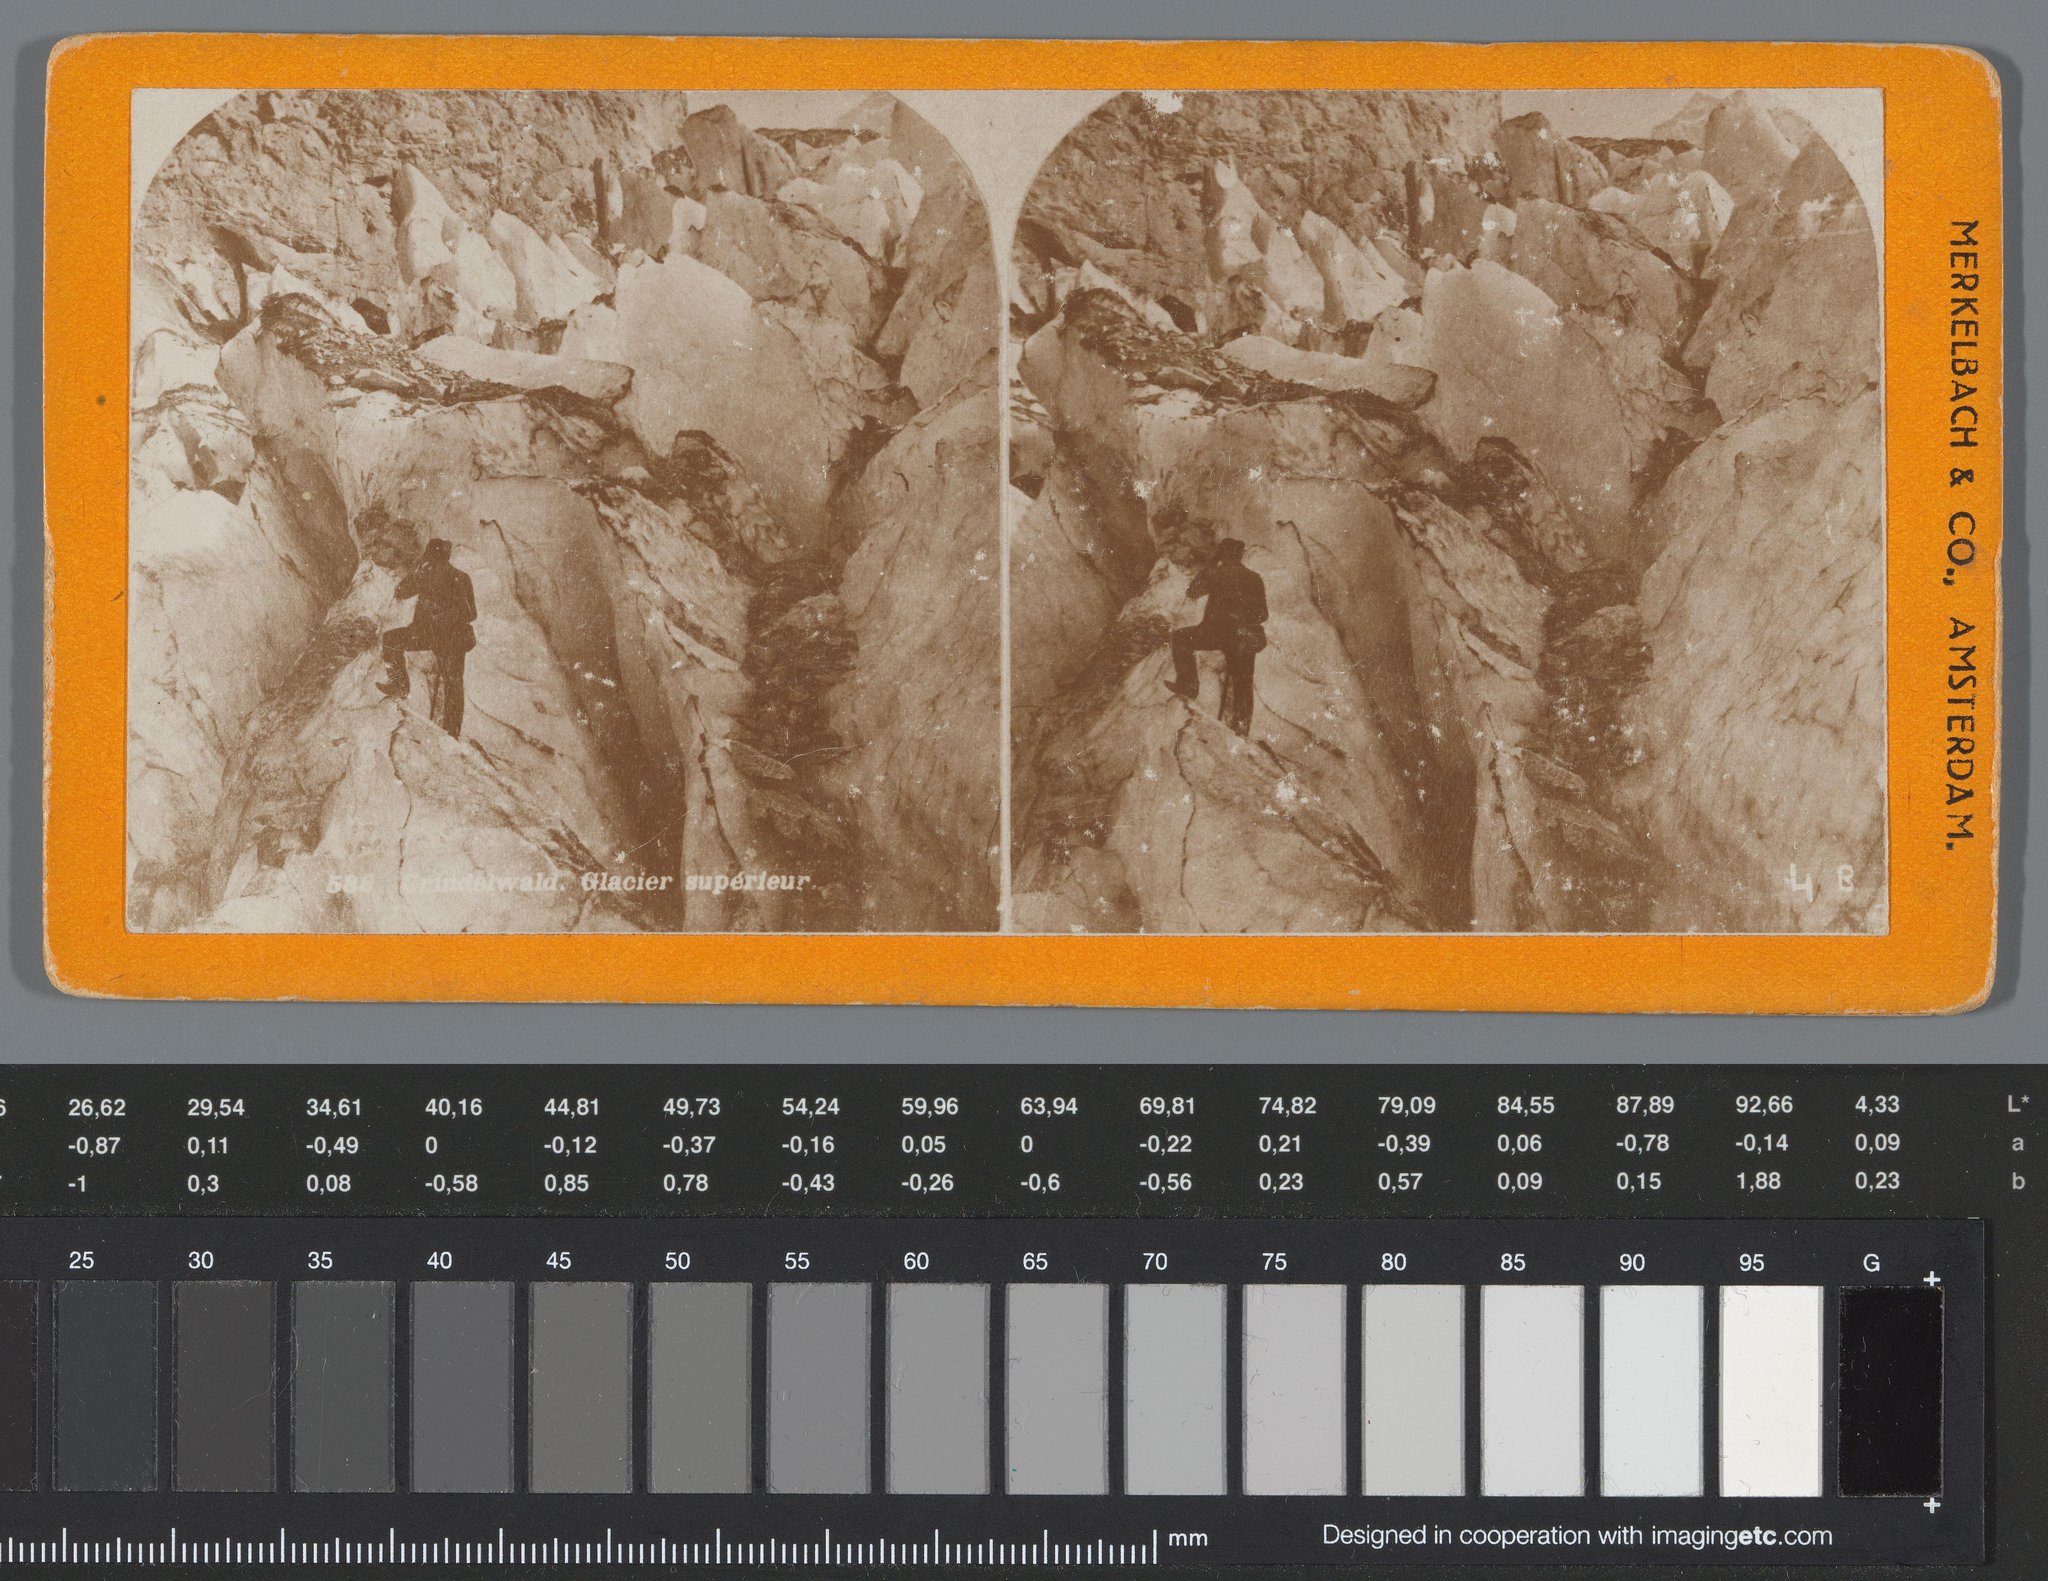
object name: stereograph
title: Gletsjer Grindelwald, Zwitserland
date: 1905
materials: paper, cardboard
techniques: collodion silver print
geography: amsterdam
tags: grindelwald